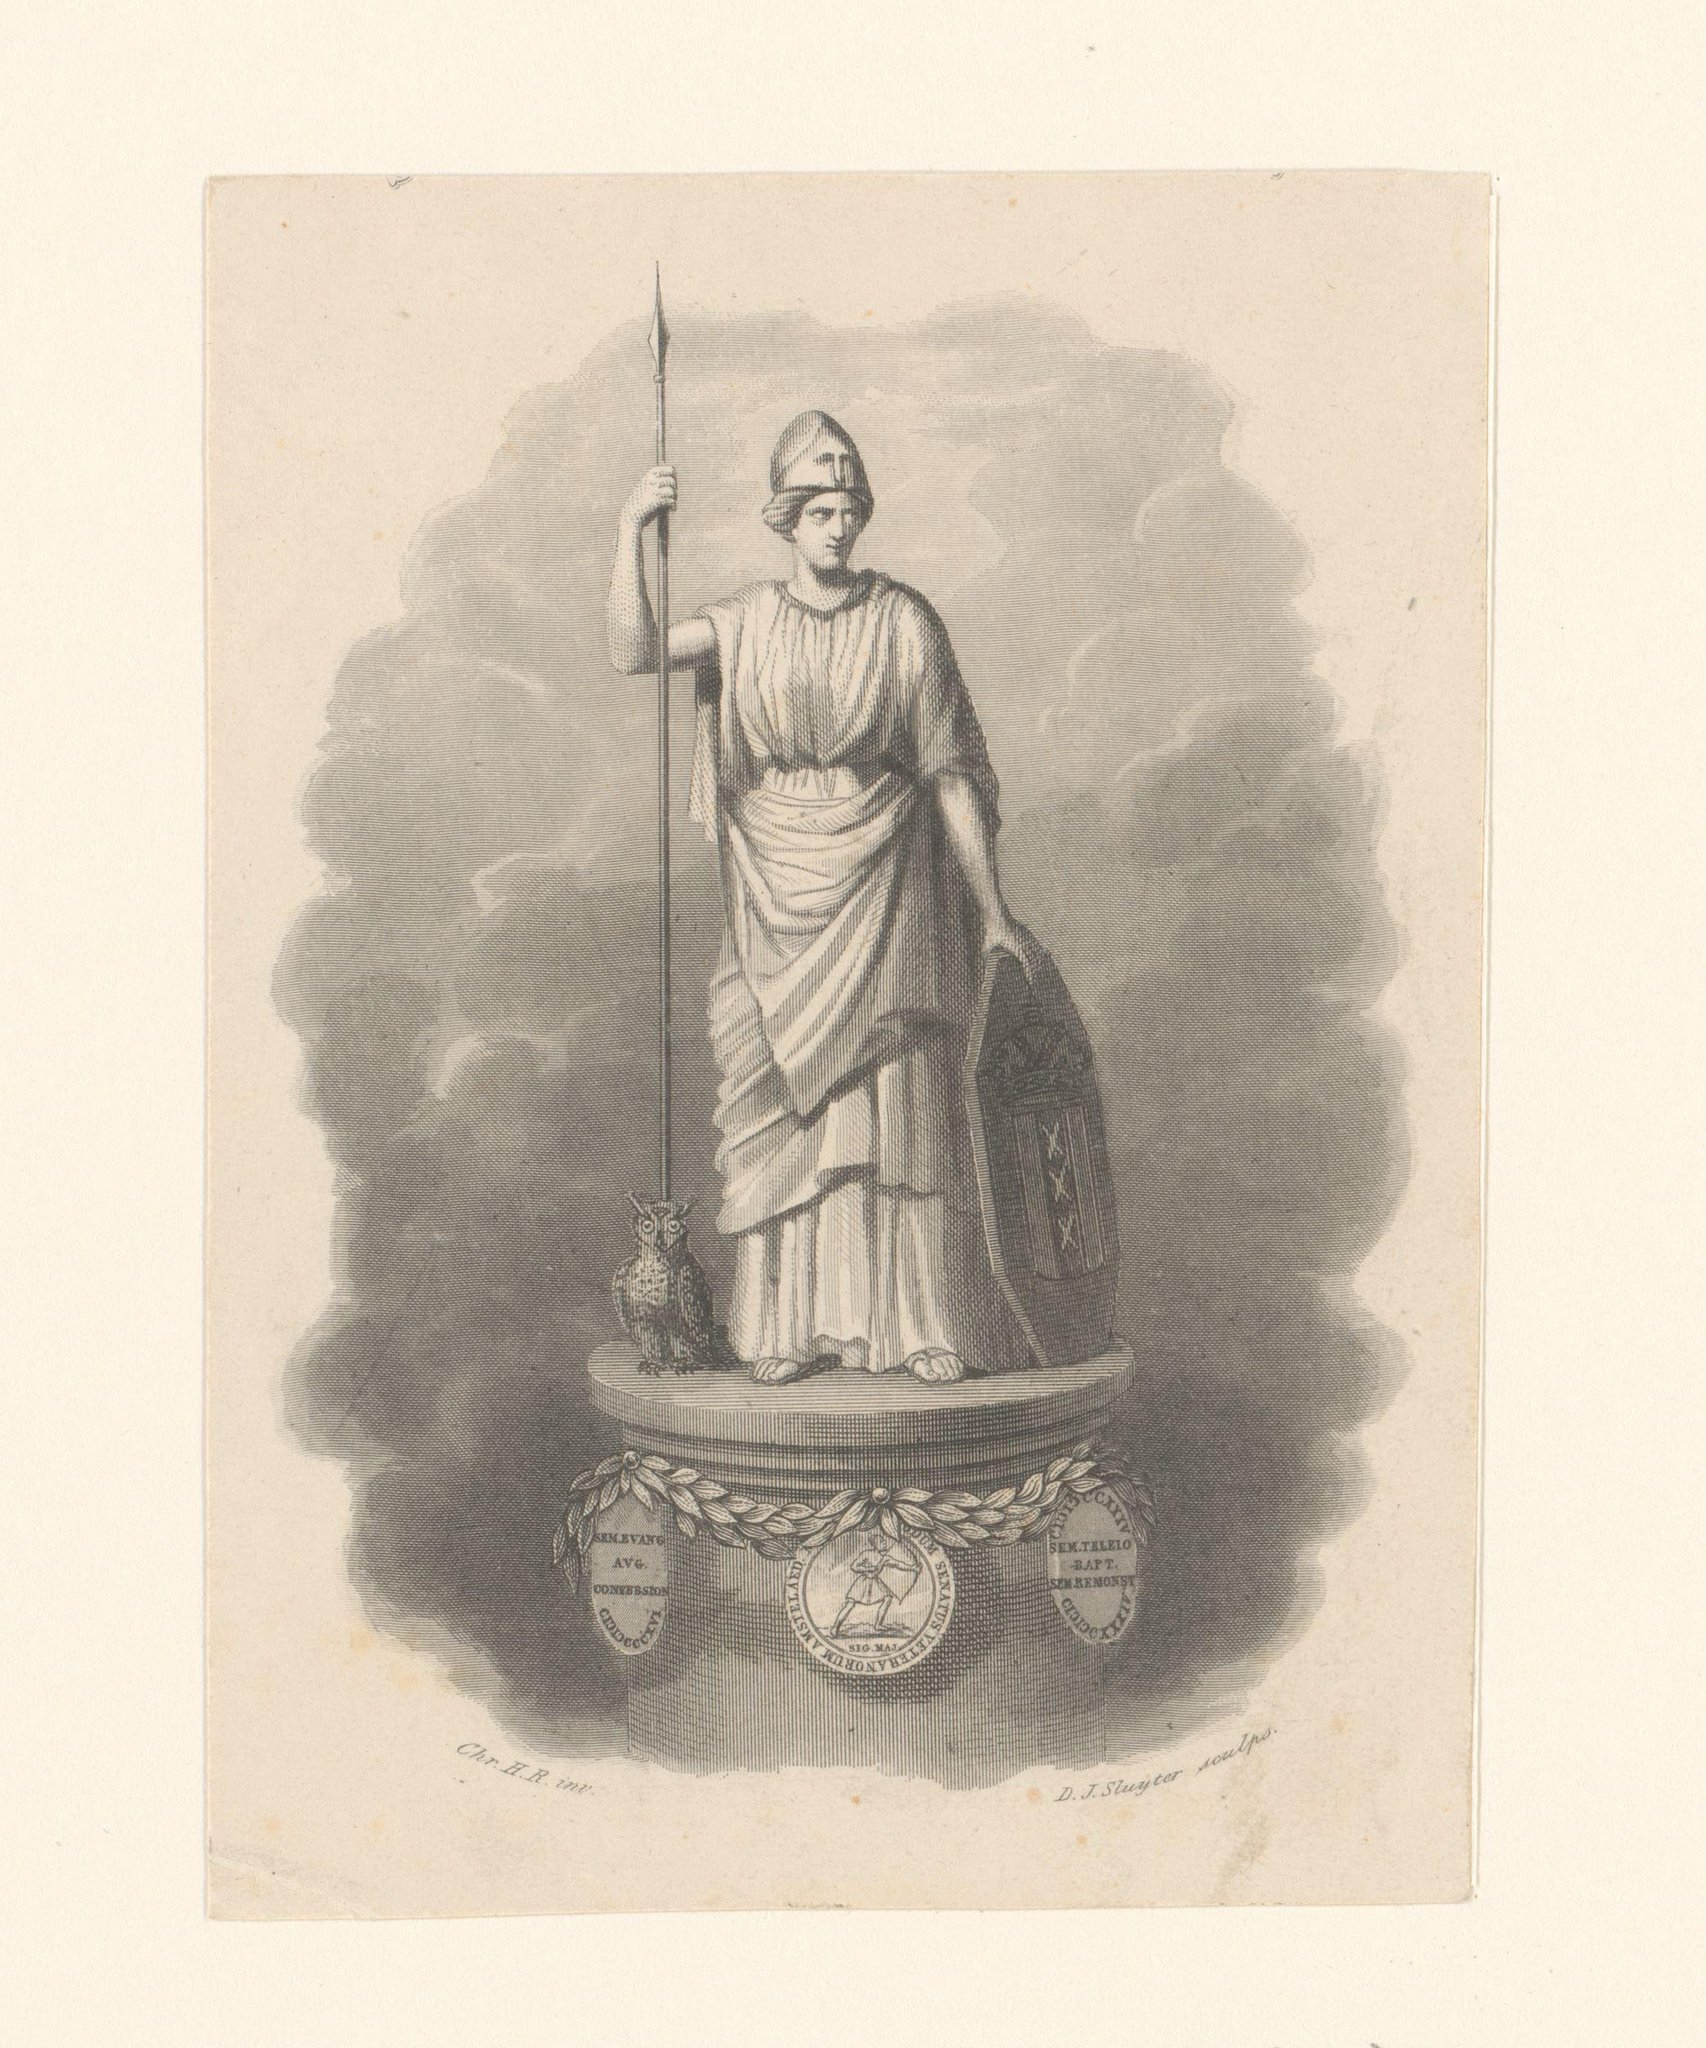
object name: print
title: Minerva met het stadswapen van Amsterdam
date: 1821-1886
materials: paper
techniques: engraving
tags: coat of arms (as symbol of the state, etc.) (+ city; municipal), (story of) minerva (pallas, athena), amsterdam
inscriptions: collector's mark: Lugt 2228